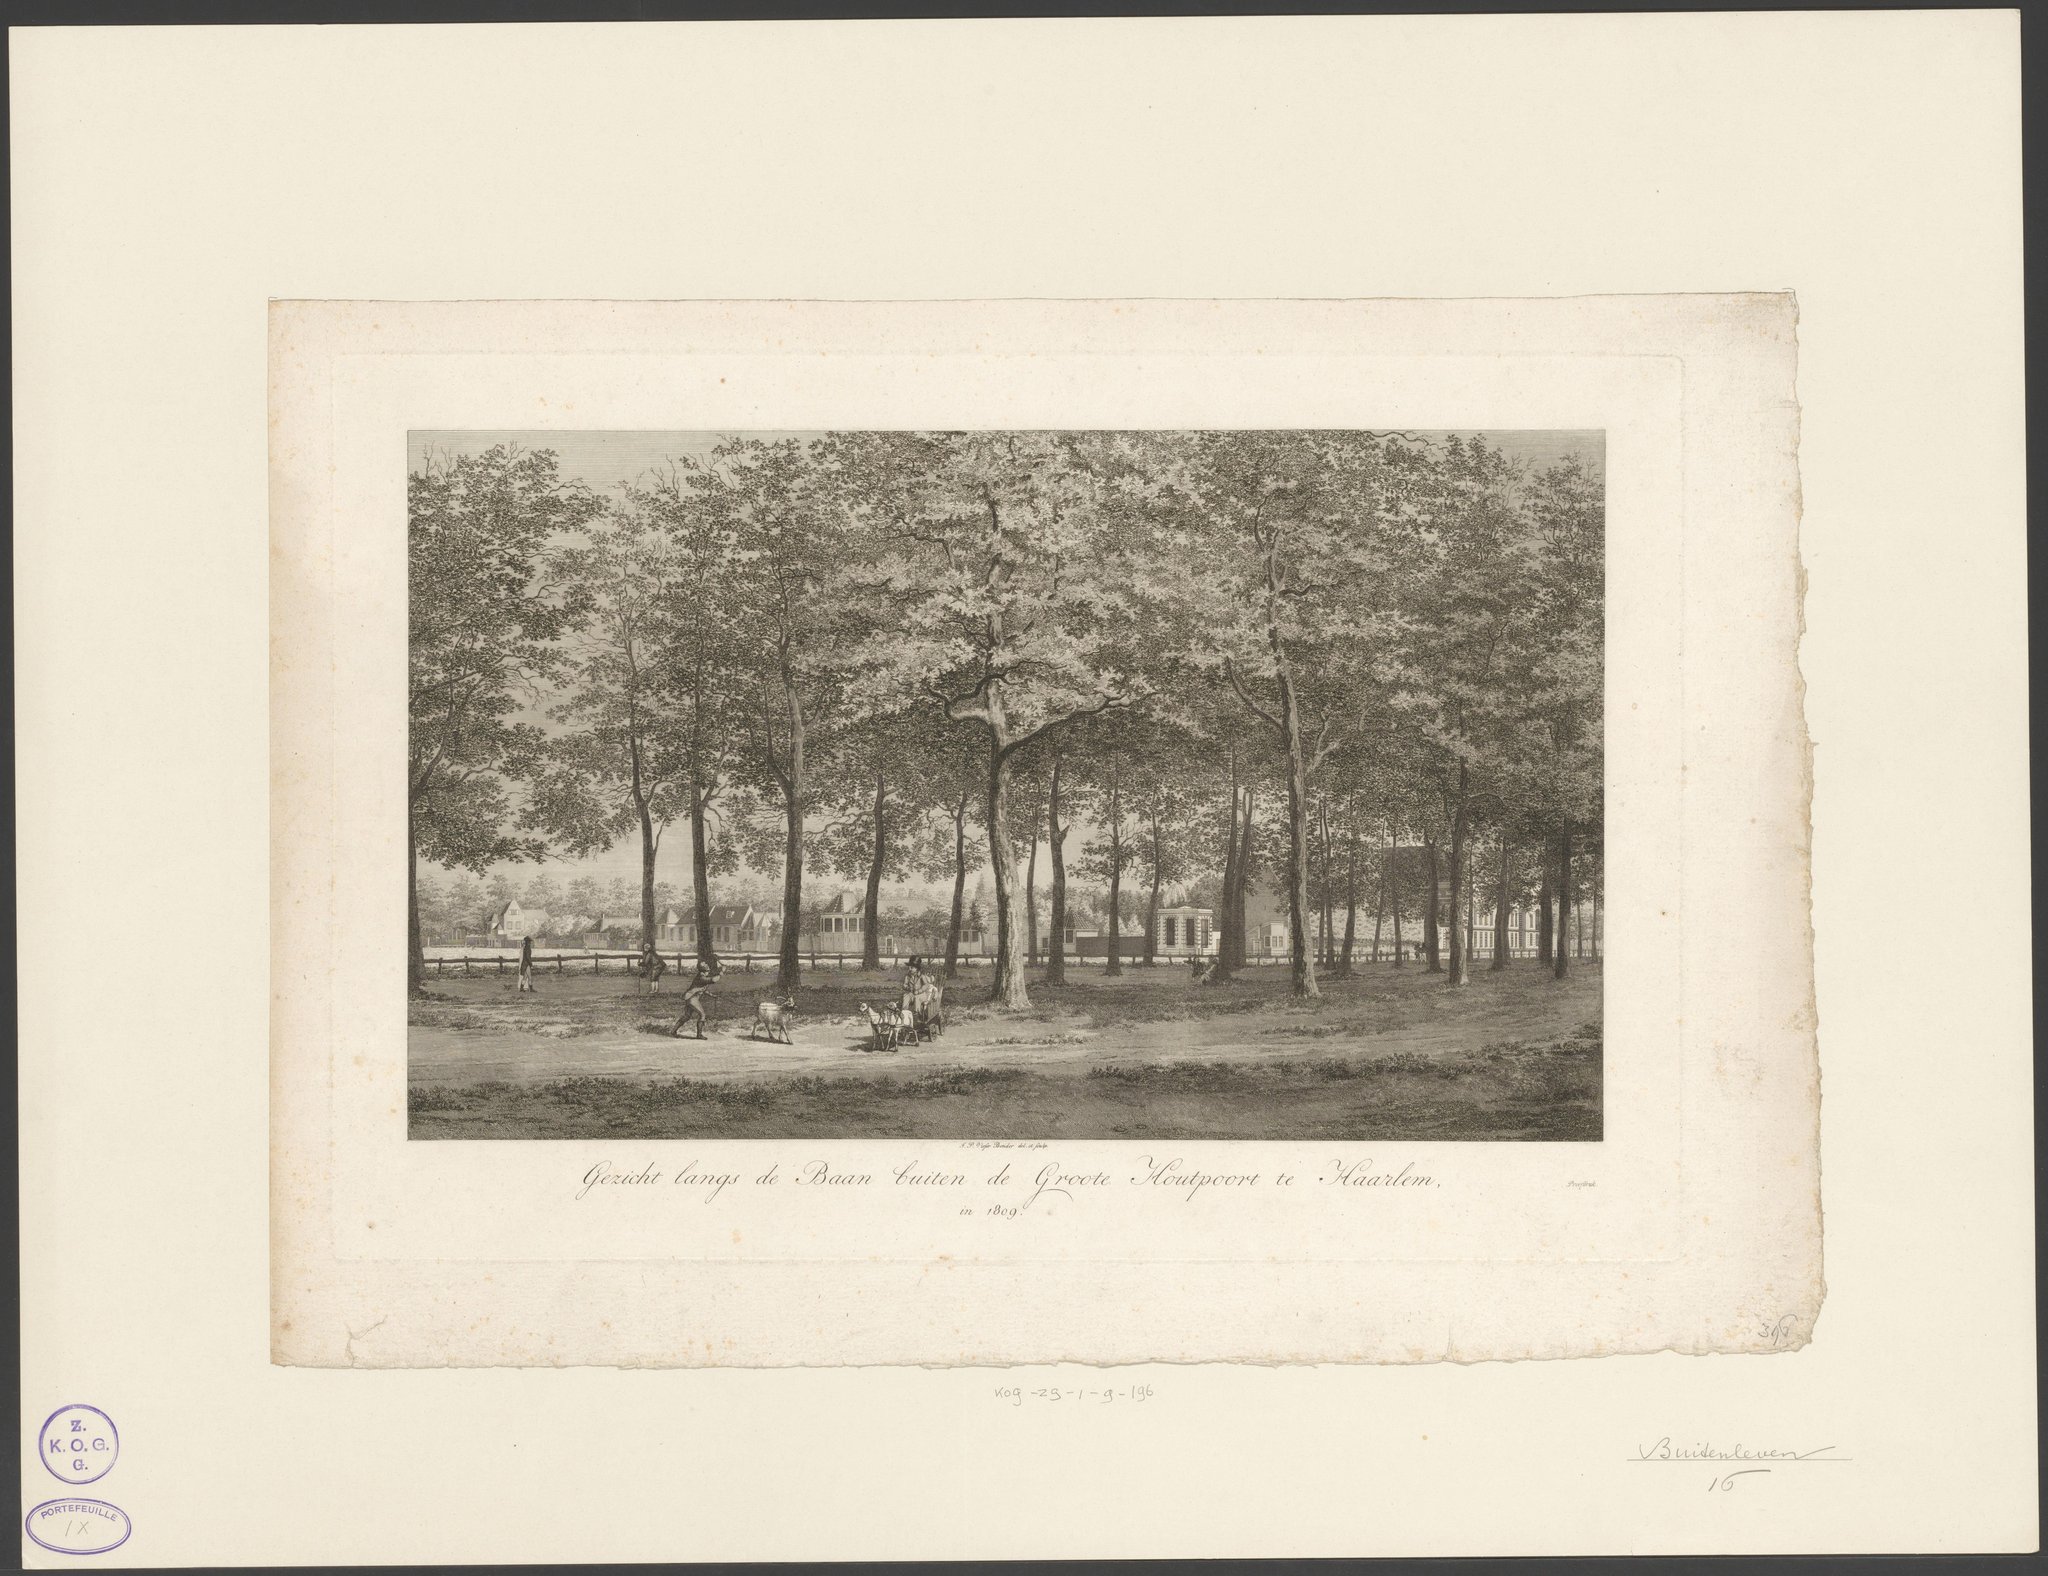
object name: print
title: Gezicht langs de Baan buiten de Groote Houtpoort te Haarlem in 1809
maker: joannes pieter visser bender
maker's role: draughtsman, print maker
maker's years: 1785-1813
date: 1809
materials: paper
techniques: engraving, etching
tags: four-wheeled vehicle drawn by one animal, race-track, goat, haarlem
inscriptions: collector's mark: Lugt 1641, stamp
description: Gezicht vanaf de Dreef over de Baan of Koekamp op de buitenplaatsjes aan de rand van de carré, die wel wordt aangeduid met Krommelaancomplex. Op de achtergrond rechts Paviljoen Welgelegen op de hoek van de Dreef en de Paviljoenslaan. Op de voorgrond twee jongens met een geit en een bokkenwagen. Onderwerpsrubrieken binnen de Atlas Zeden en Gewoonten: Handel, nijverheid en verkeer, Buitenleven.